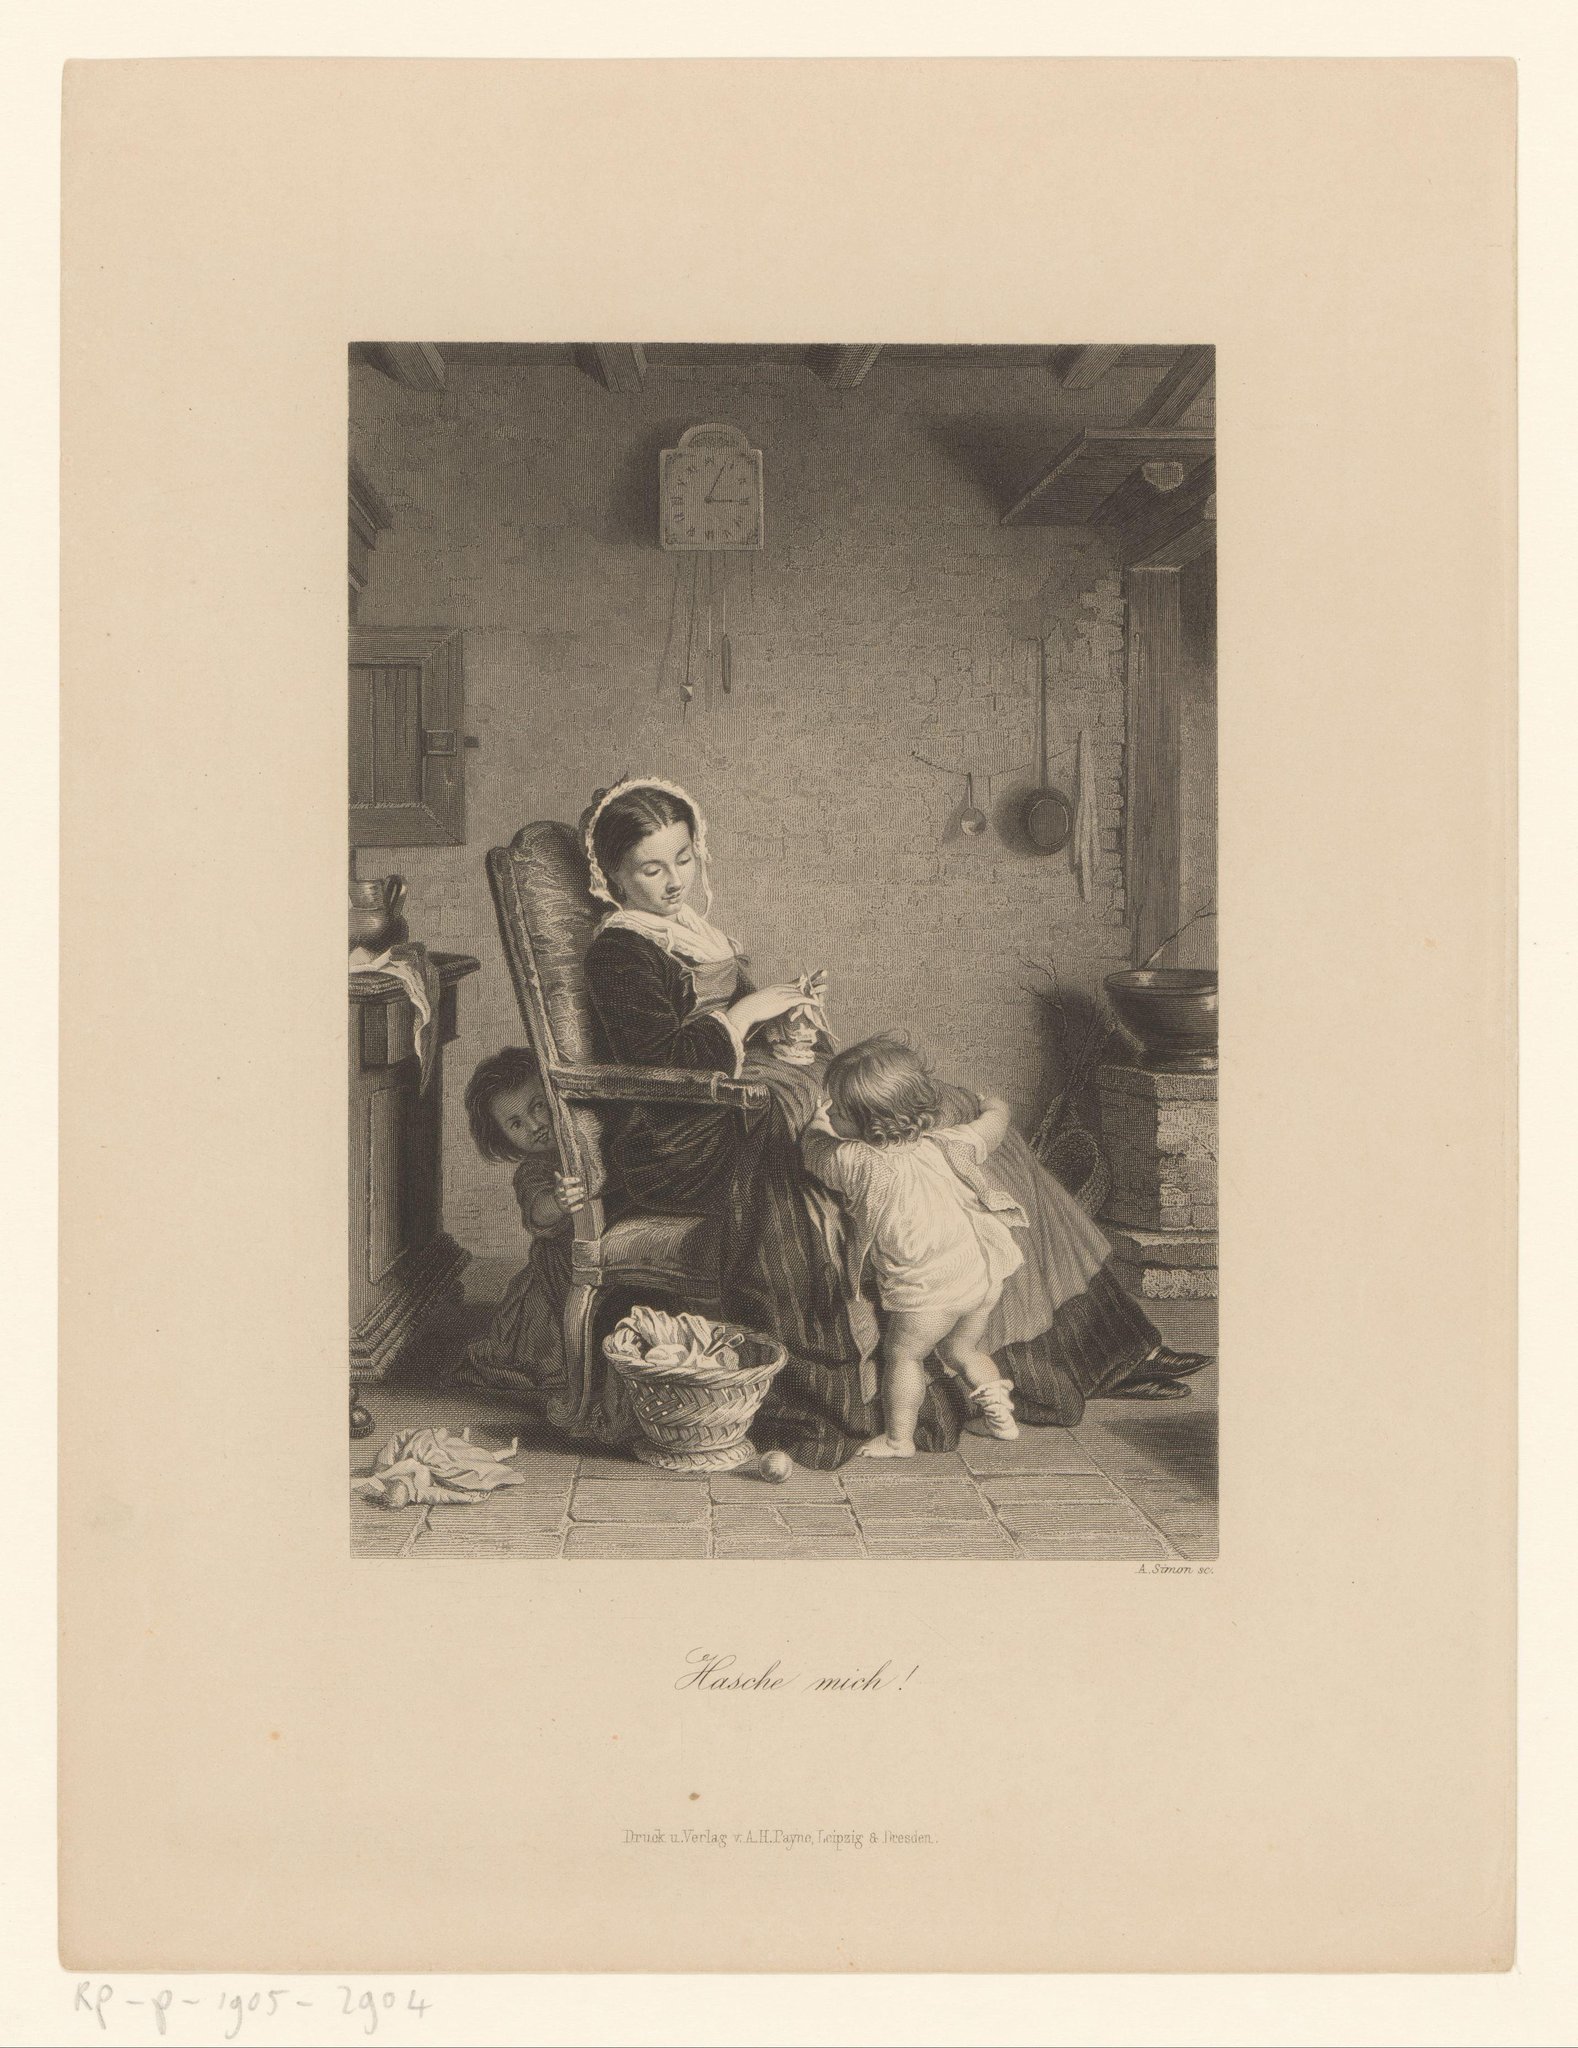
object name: print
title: Hasche mich!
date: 1800-1899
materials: paper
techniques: engraving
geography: leipzig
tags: hide-and-seek, family life at home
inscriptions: collector's mark: Lugt 2228